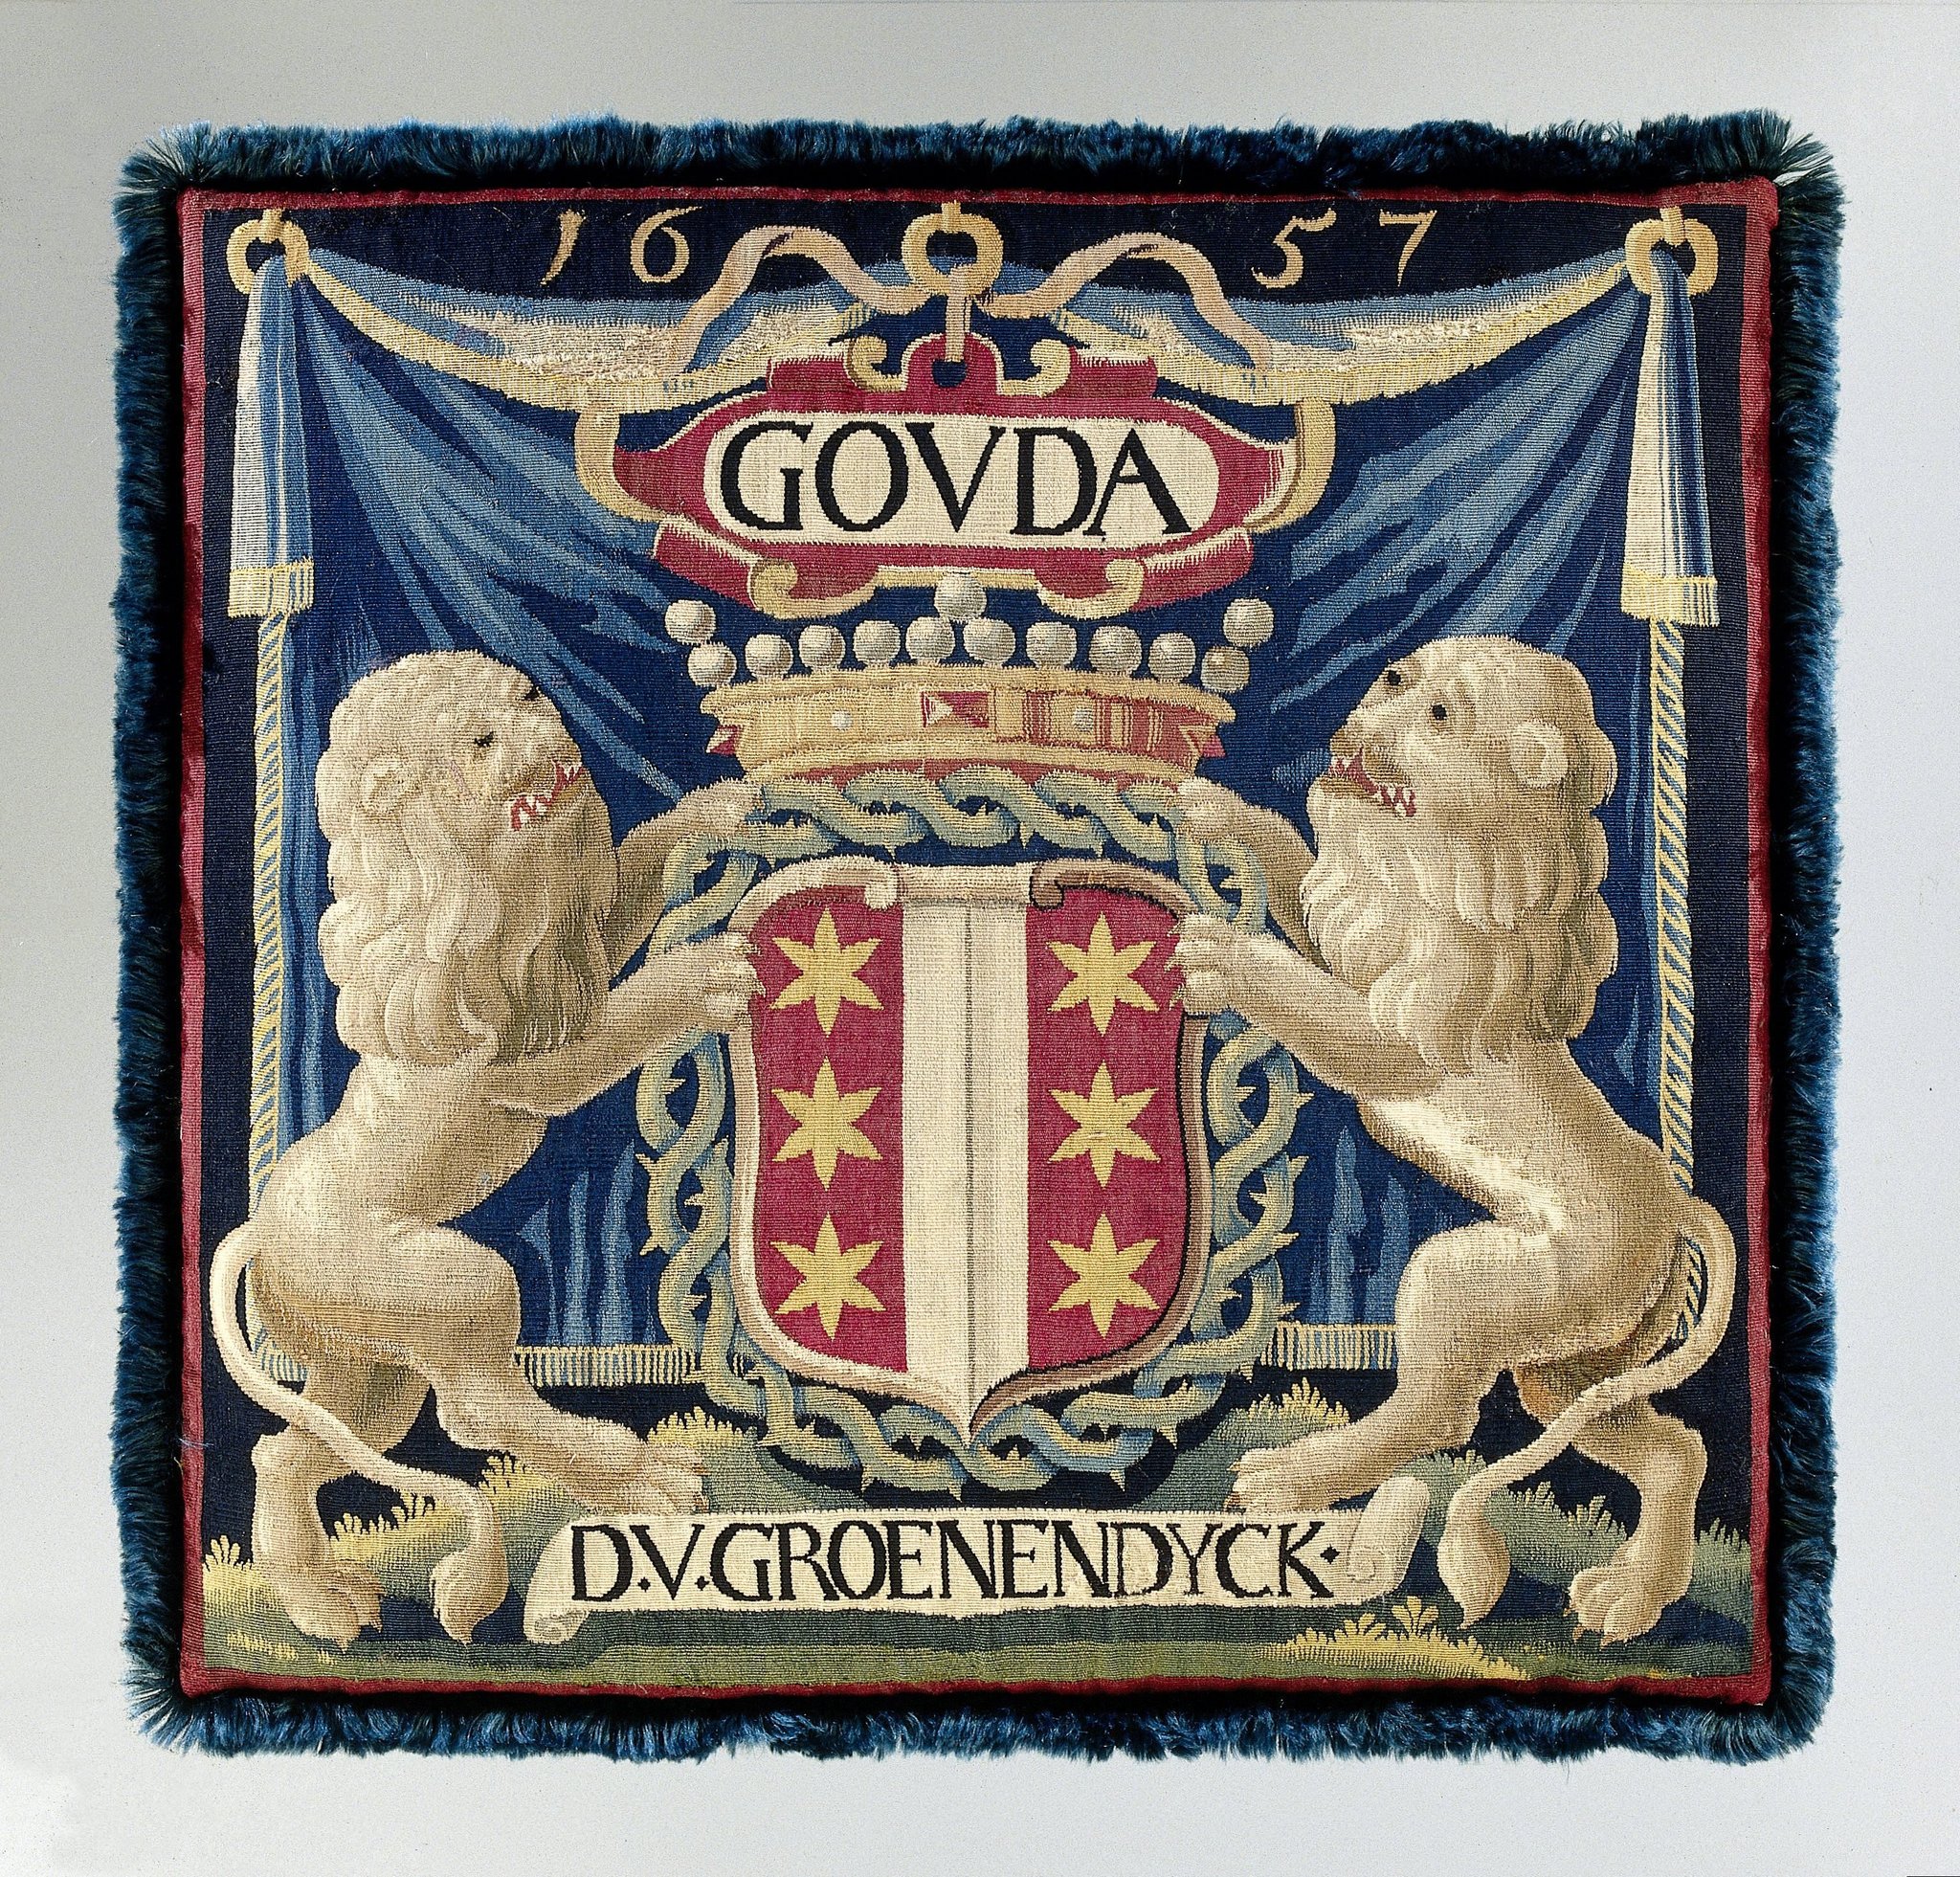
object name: magistratenkussen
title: Kussenovertrek met het stadswapen van Gouda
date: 1657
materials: linen, silk, wool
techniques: tapestry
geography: gouda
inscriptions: date: ‘1657’, inscription: ‘D.V.GROENENDYCK.’, inscription: ‘GOVDA’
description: Kussenovertrek in tapisserietechniek met afbeelding van het wapen van Gouda en met de naam D.V. GROENENDIJCK en met het jaartal 1657.